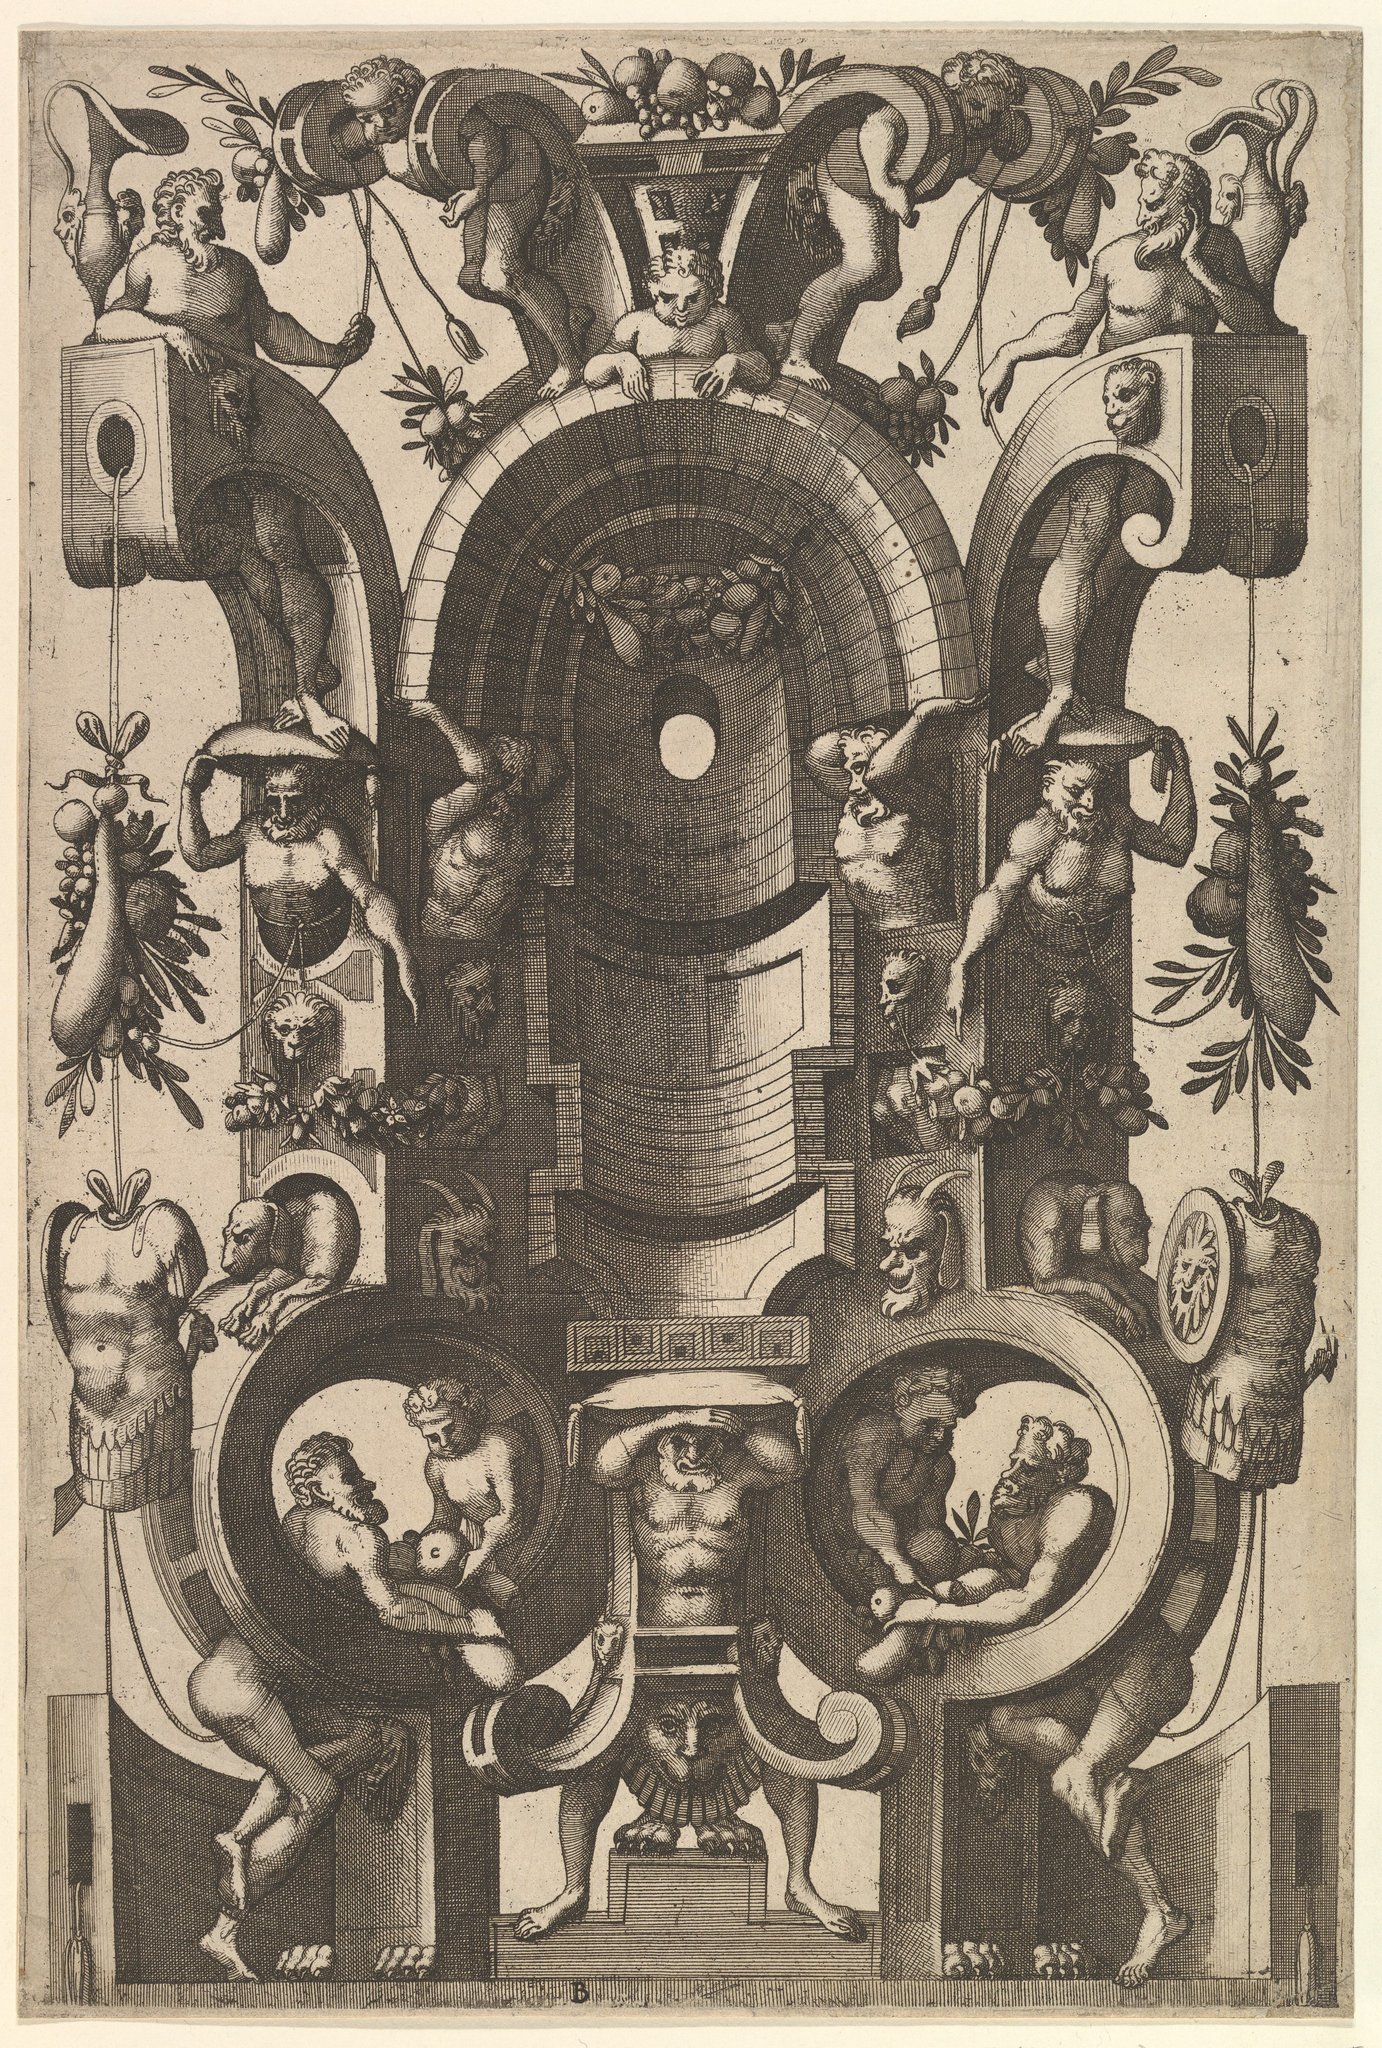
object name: book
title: Niche in the Form of a Cartouche from Veelderleij Veranderinghe van grotissen ende Compertimenten...Libro Primo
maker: johannes van doetecum i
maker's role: artist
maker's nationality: netherlandish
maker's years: 1528-1605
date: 1556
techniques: etching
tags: cartouches,male nudes